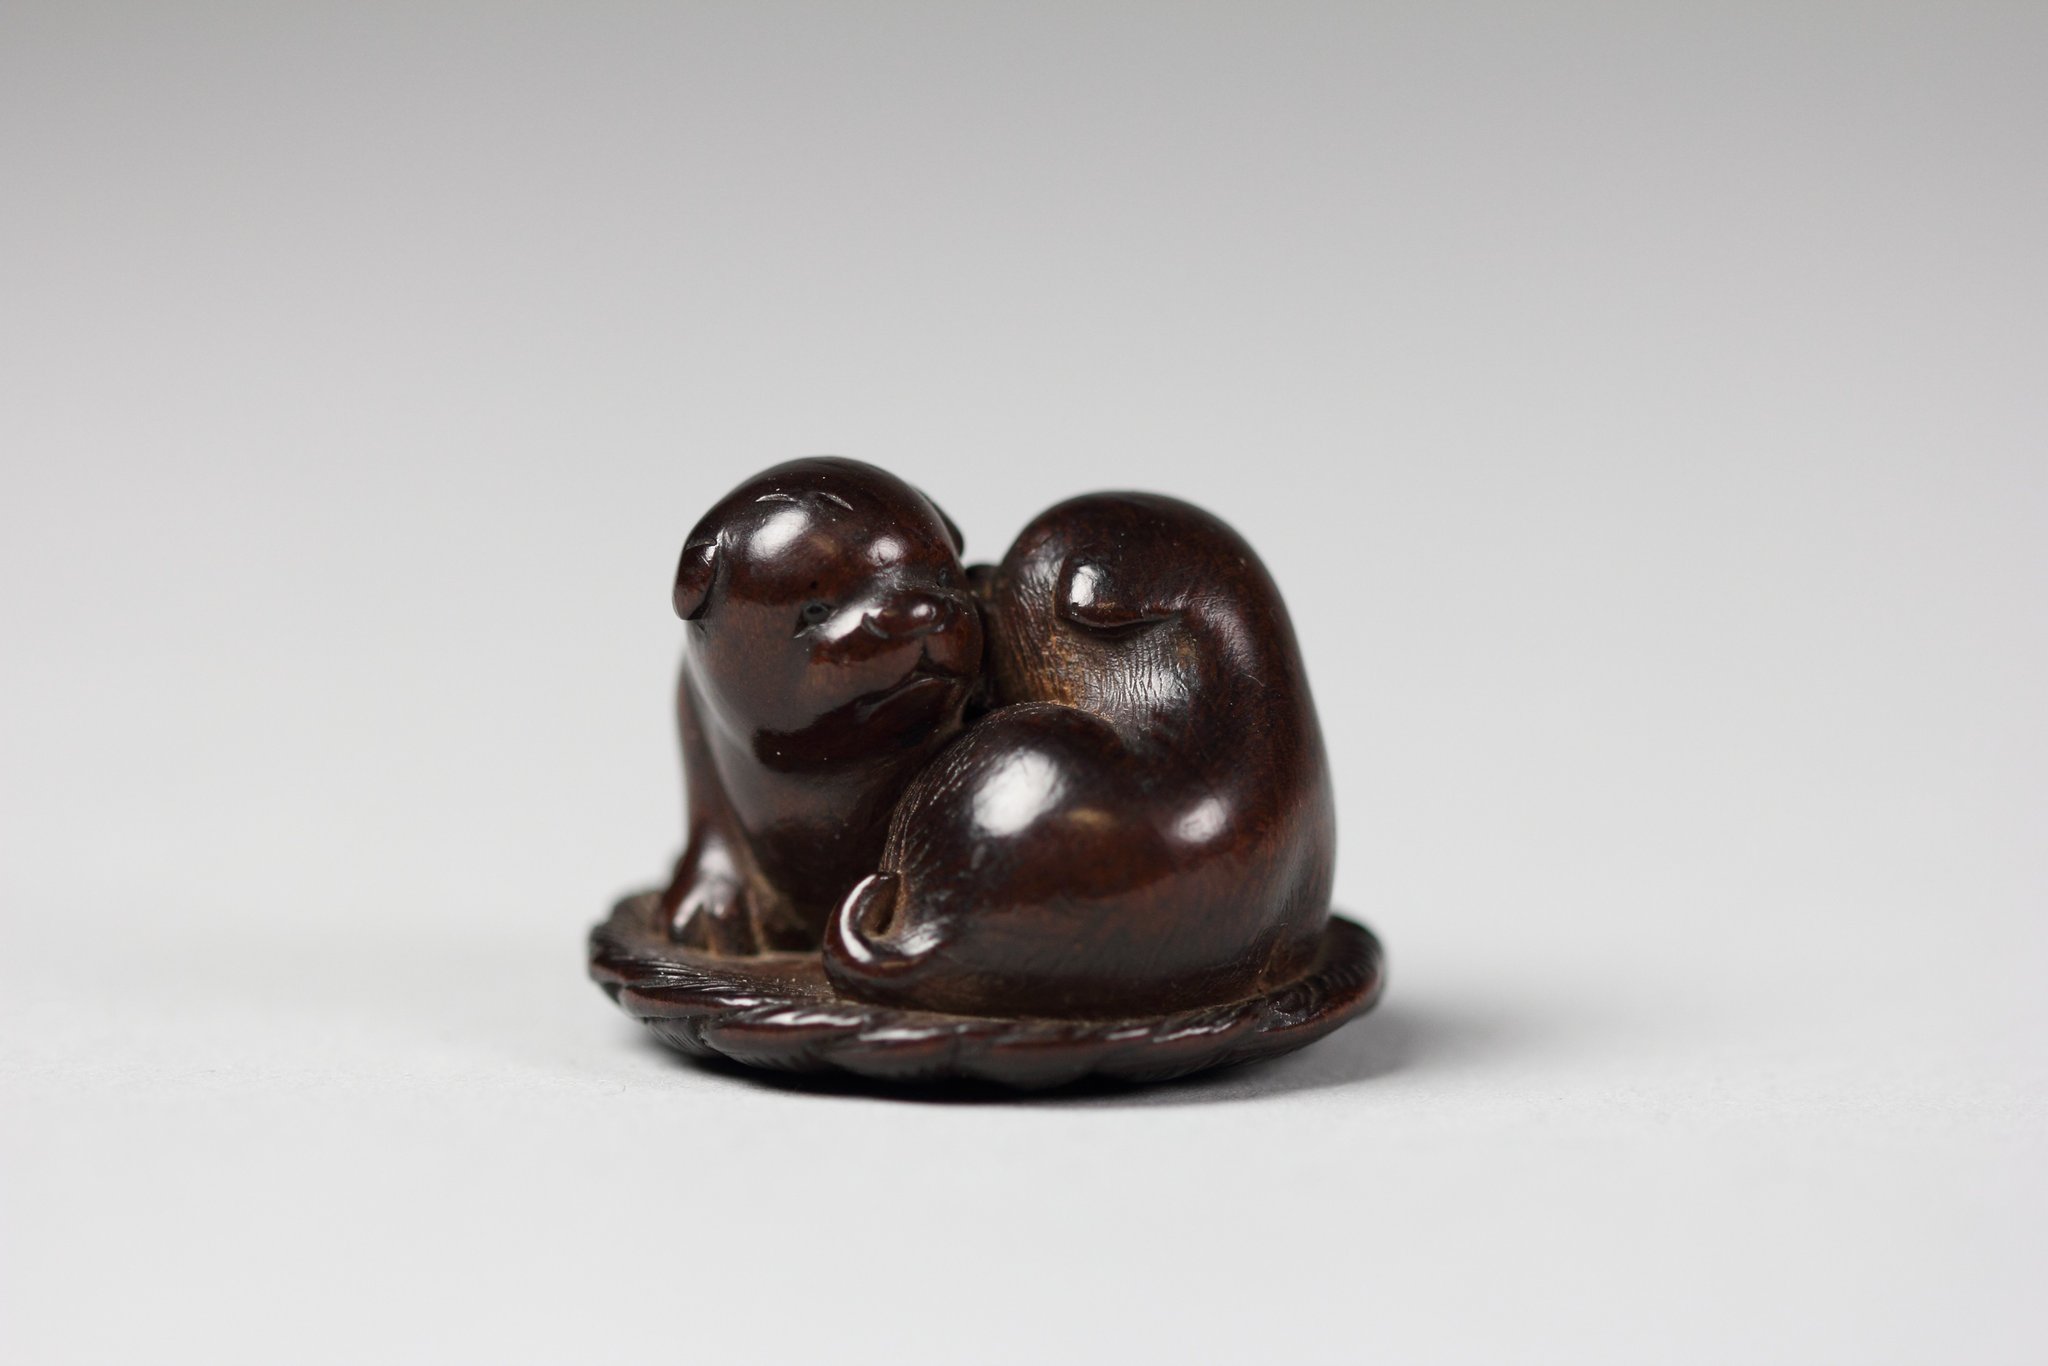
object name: netsuke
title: Netsuke of Two Dogs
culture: japanese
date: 1701-1900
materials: wood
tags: dogs